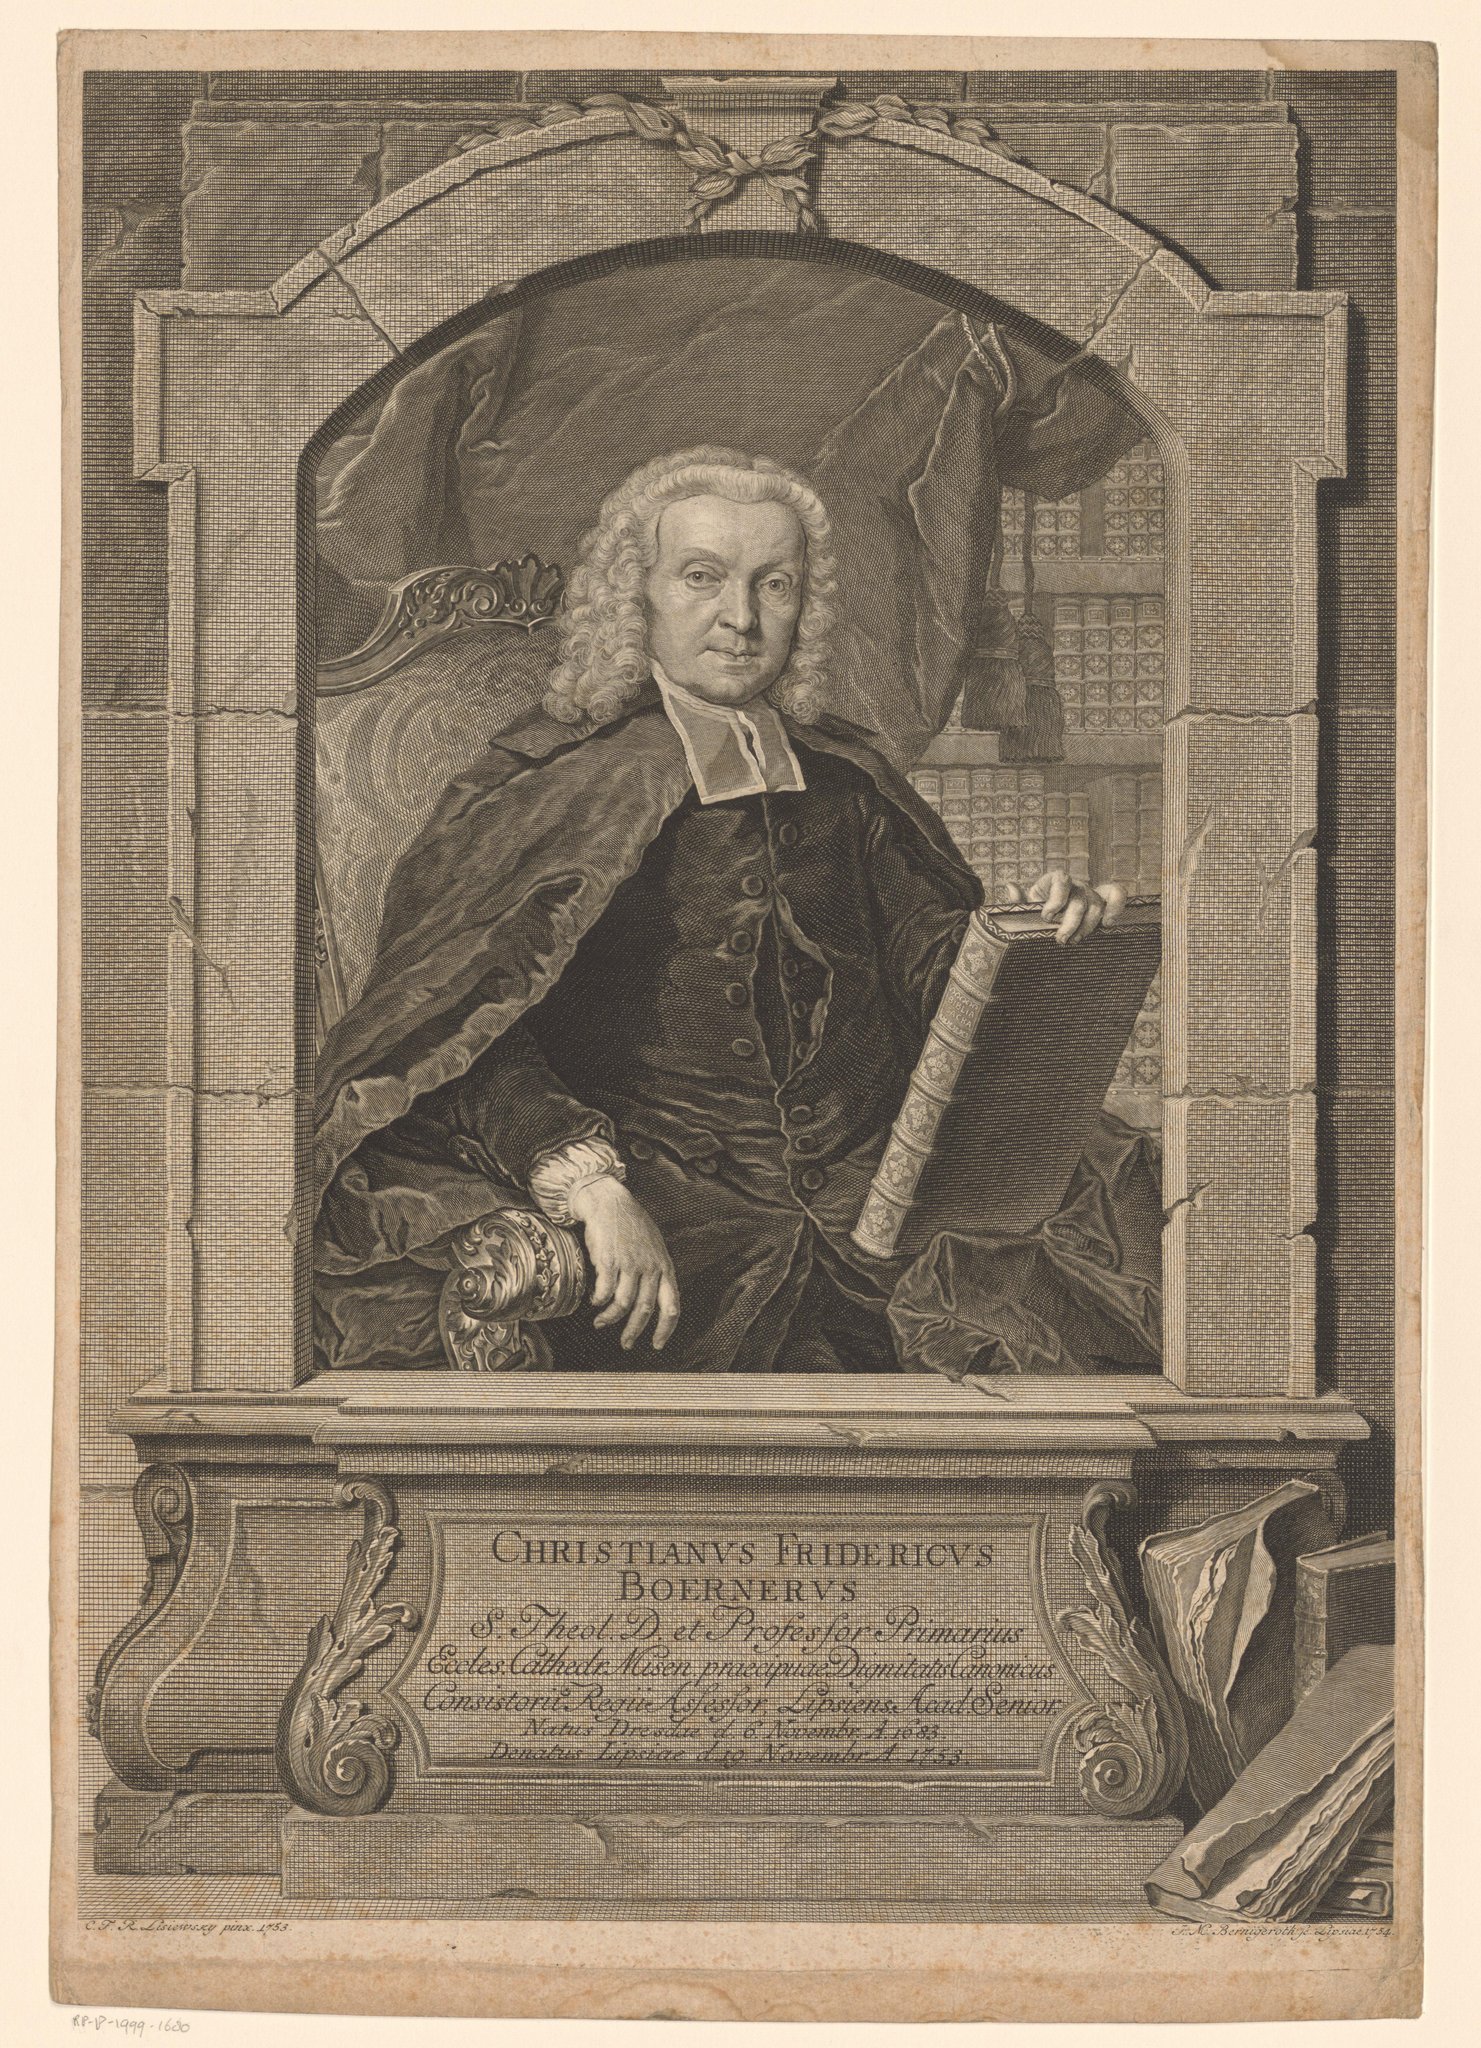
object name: print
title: Portret van Christian Friedrich Boerner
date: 1754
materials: paper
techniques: engraving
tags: bookshelves, theologian, historical persons, book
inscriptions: collector's mark: Lugt 2760, collector's mark: Lugt 2228